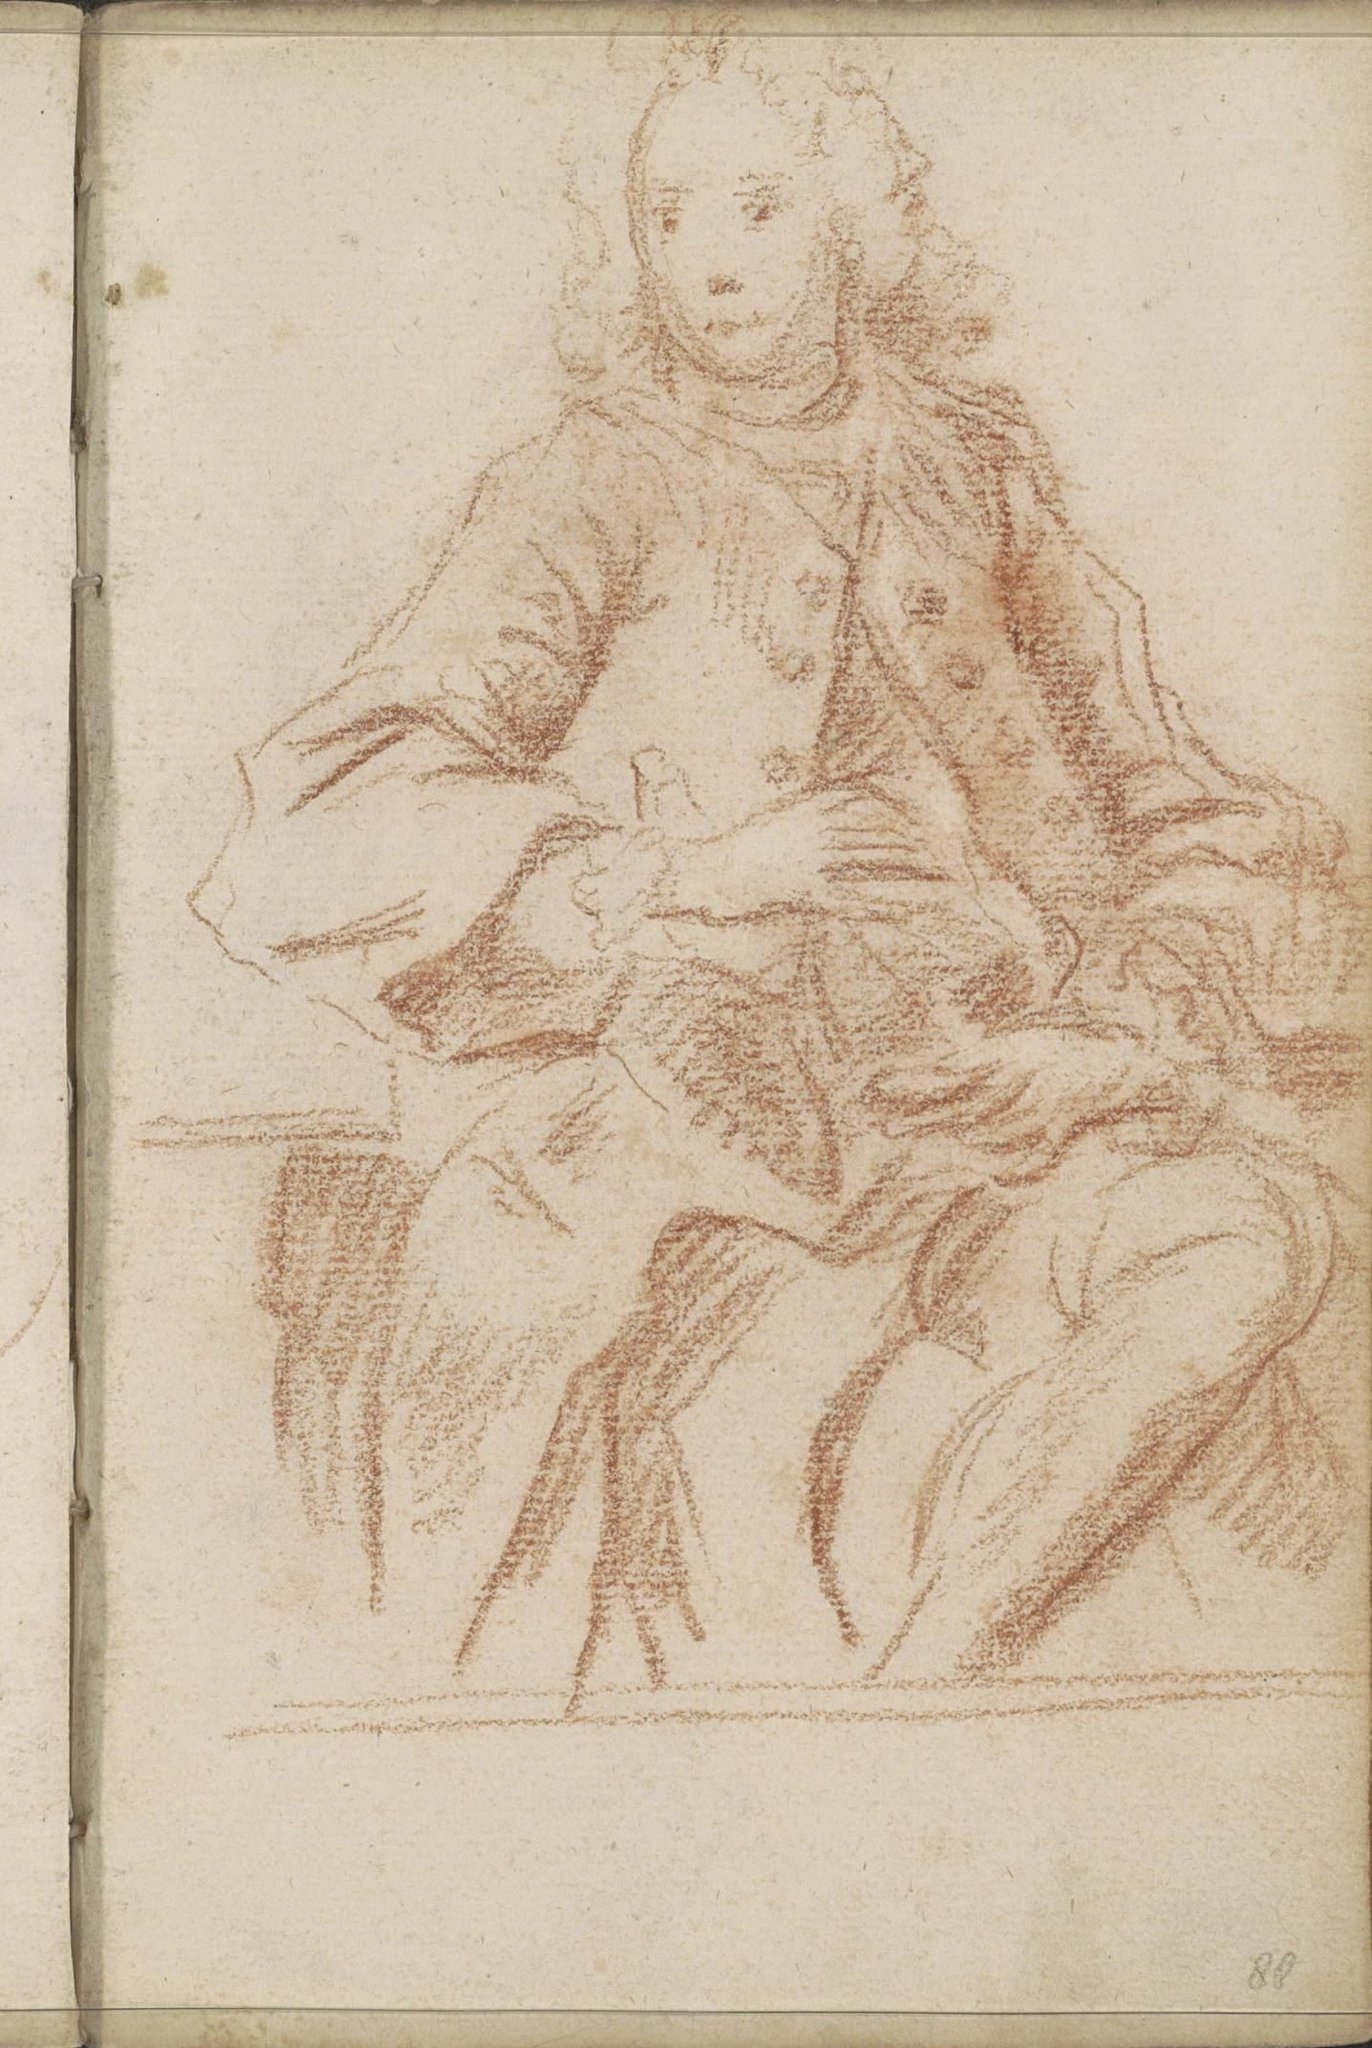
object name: sketchbook leaf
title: Zittende man voor een tafel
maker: petrus johannes van reysschoot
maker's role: draughtsman, print maker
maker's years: 1702-1772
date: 1710-1772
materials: chalk, paper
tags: sitting figure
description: Blad 88 recto uit een schetsboek met 105 bladen.